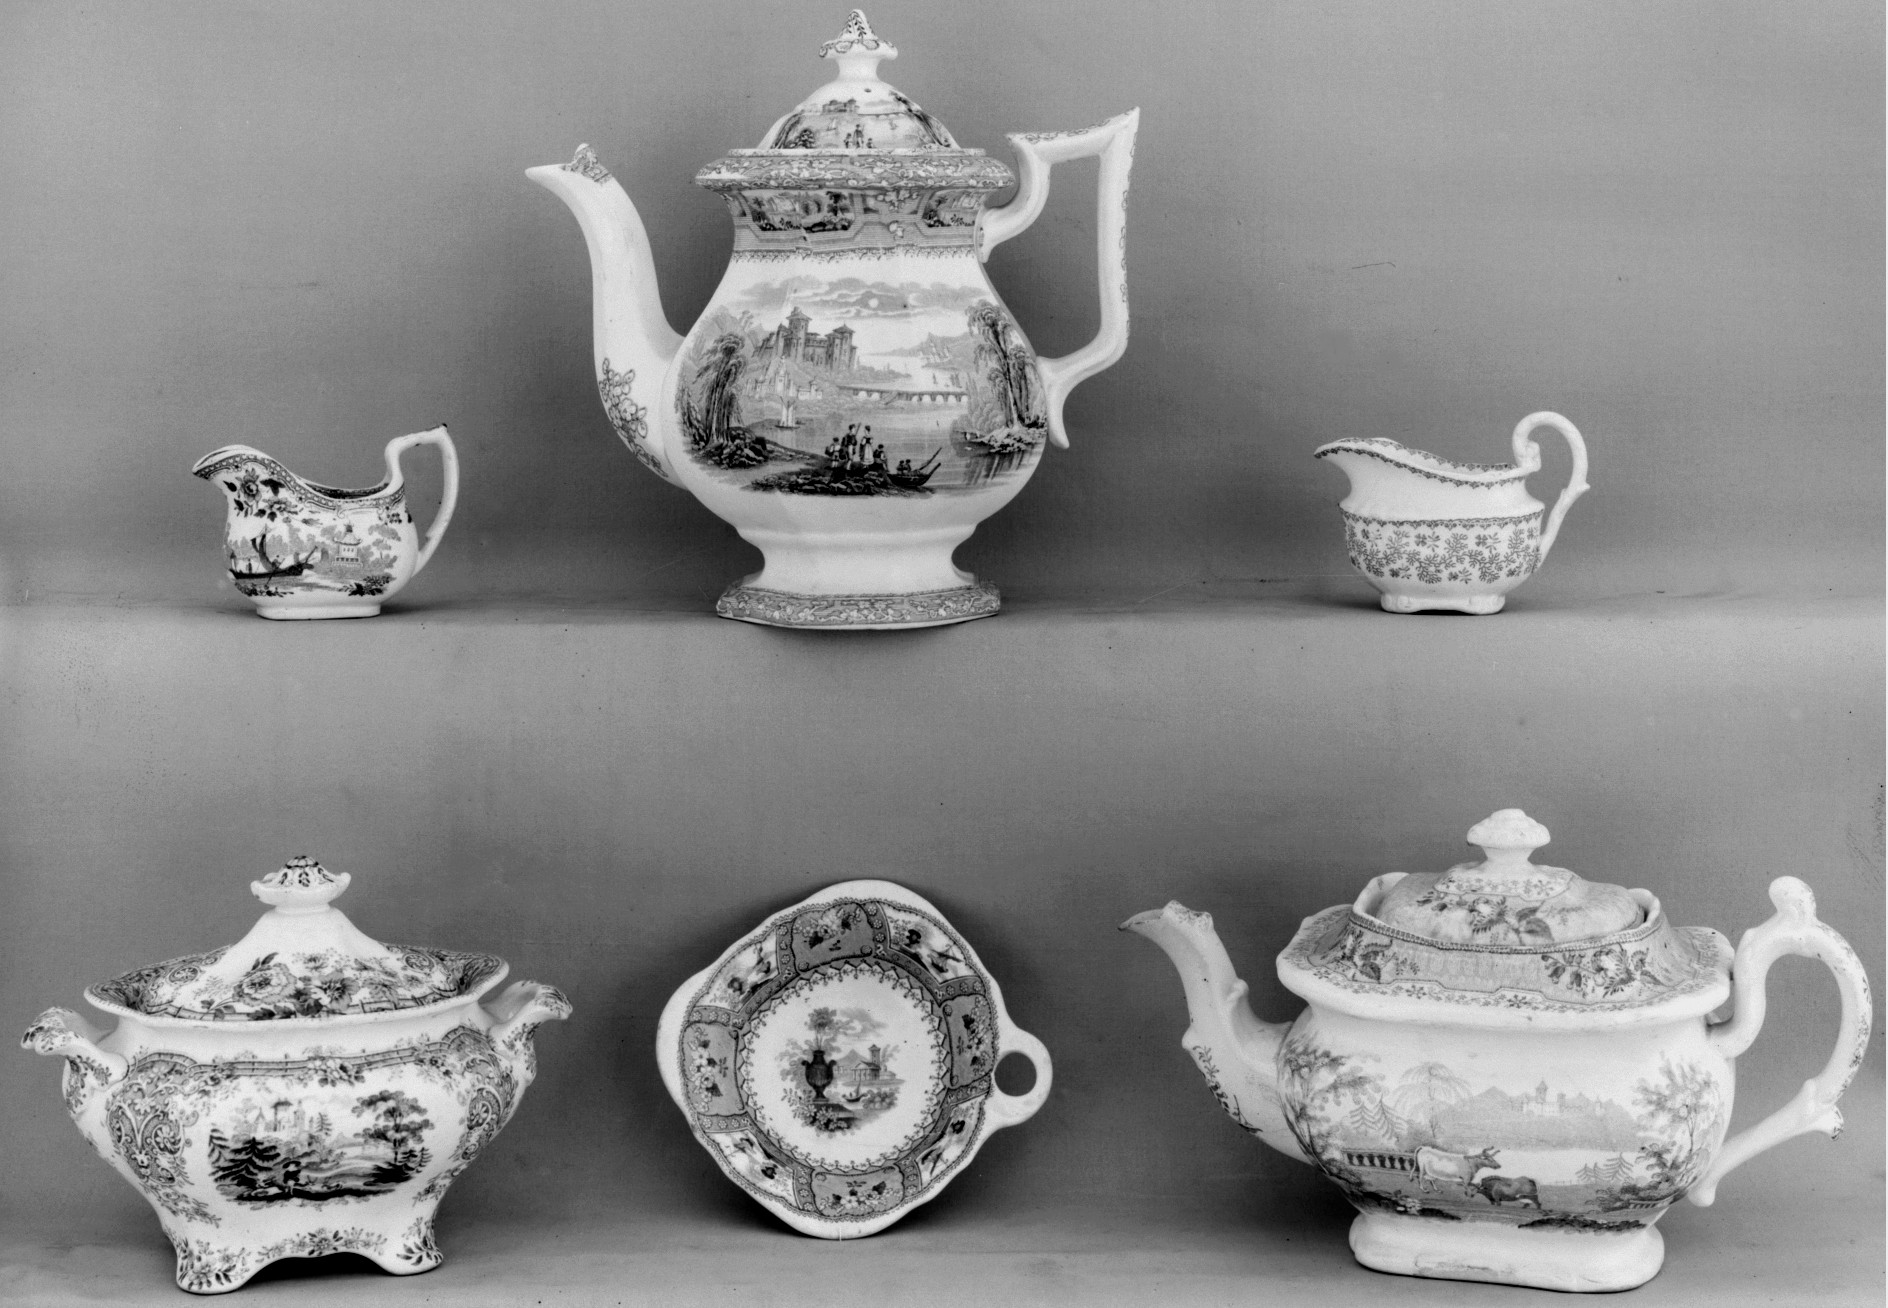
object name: cream jug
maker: ridgway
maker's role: maker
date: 1701-1900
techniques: printing